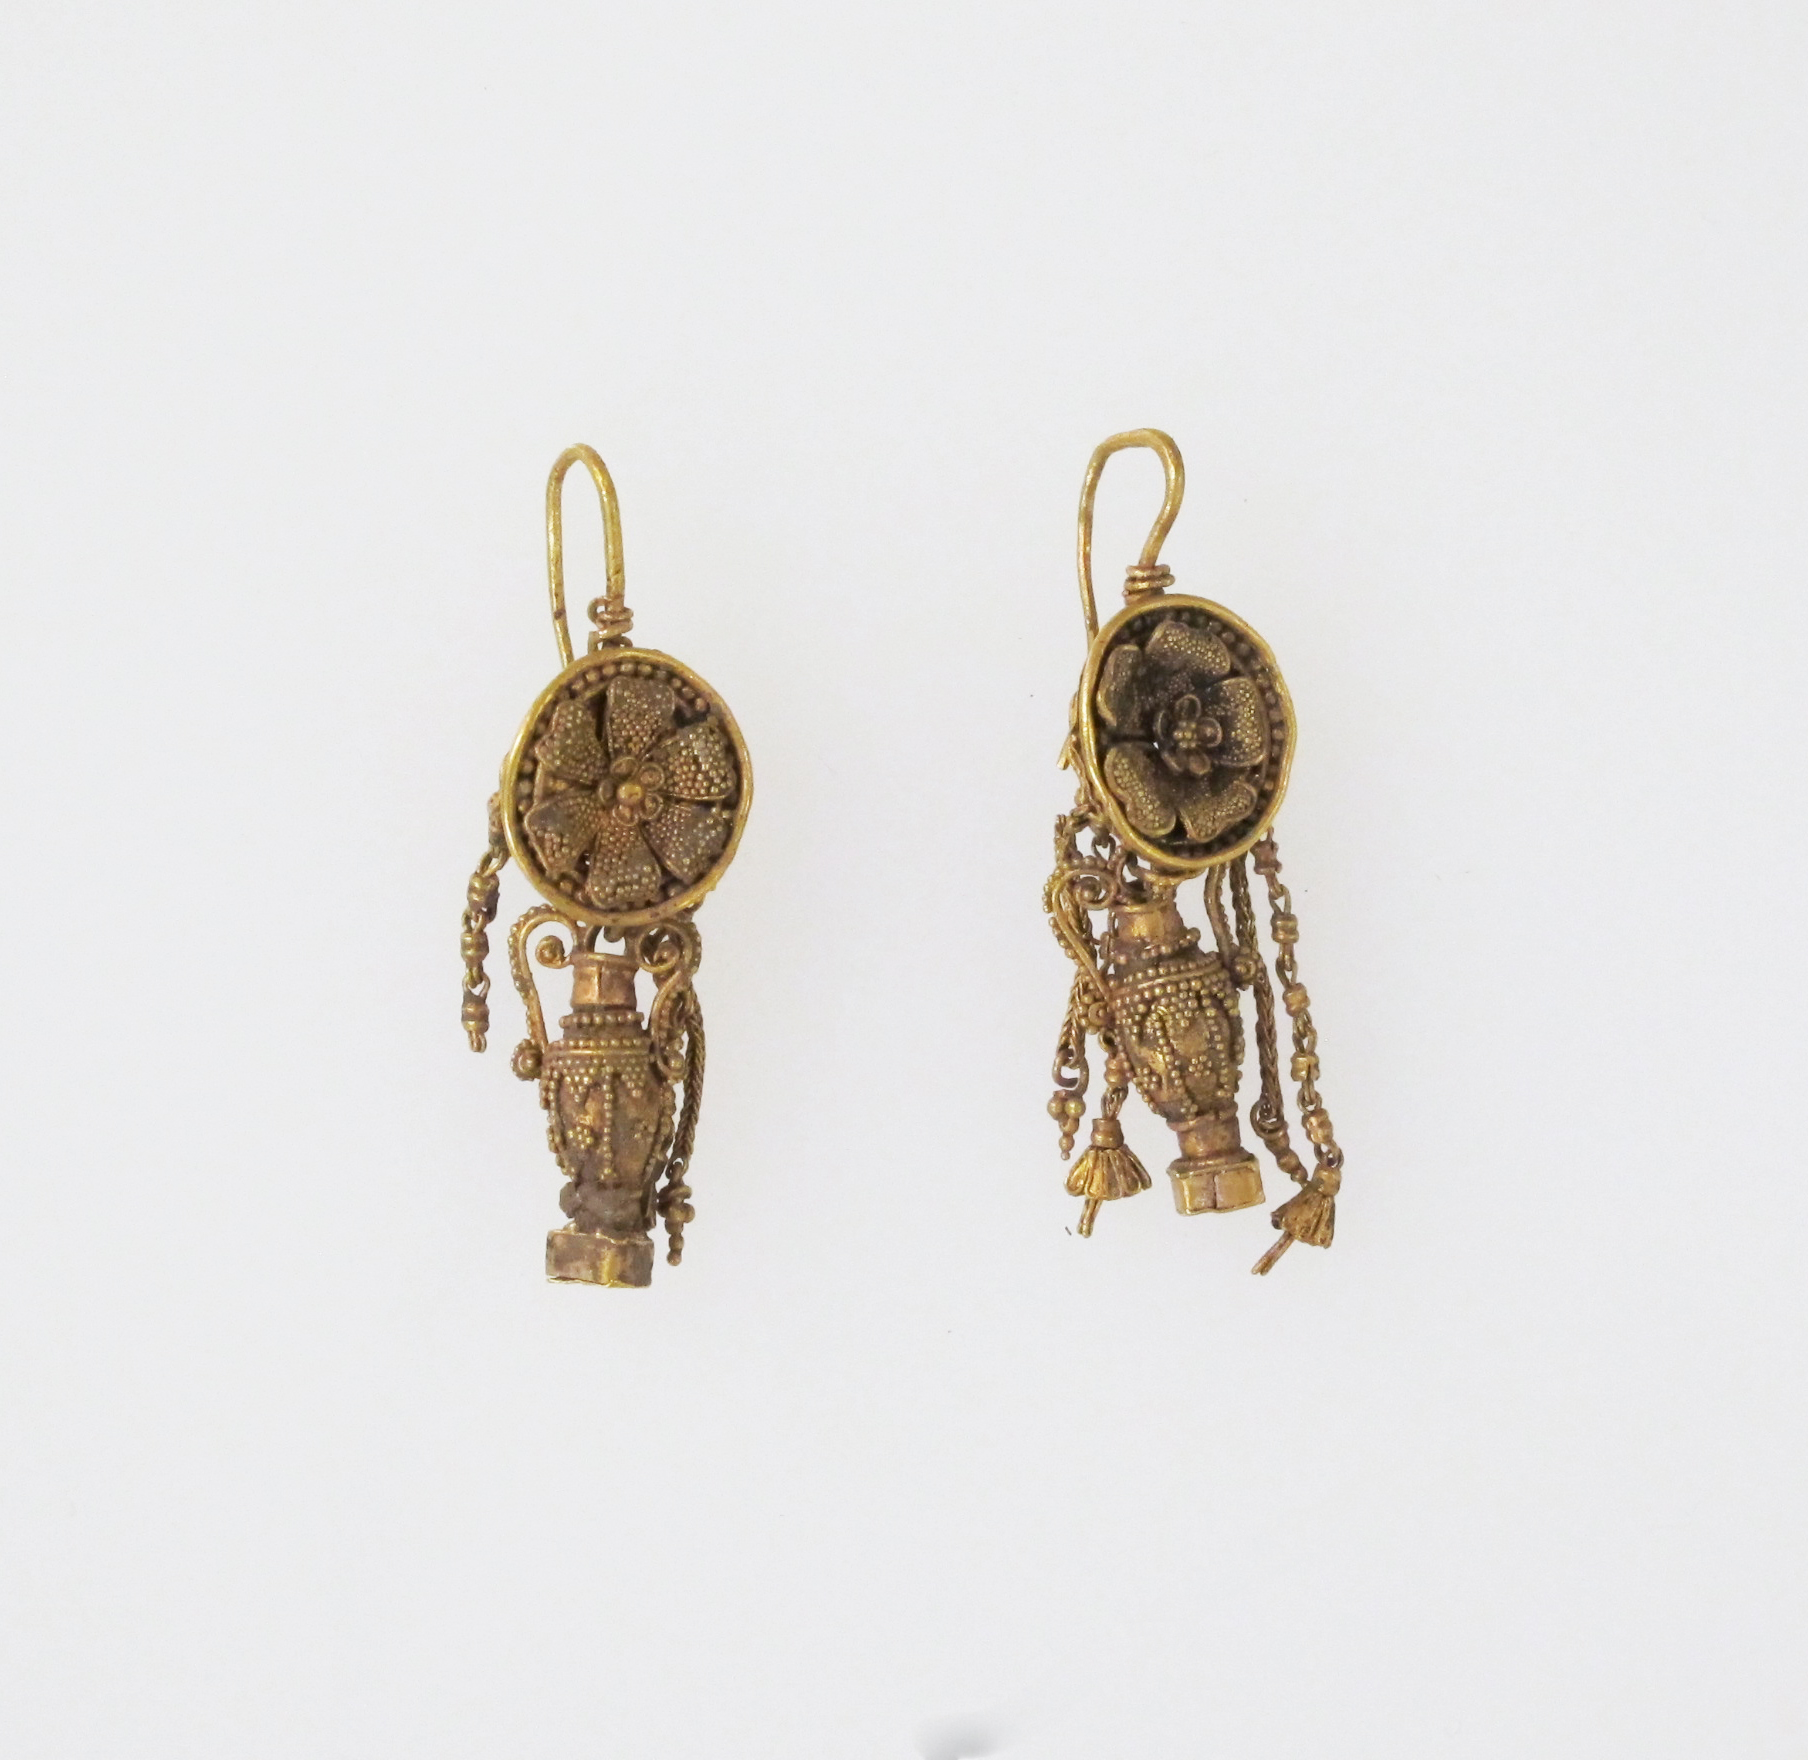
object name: earring with pendant amphora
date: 400-201 BCE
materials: gold